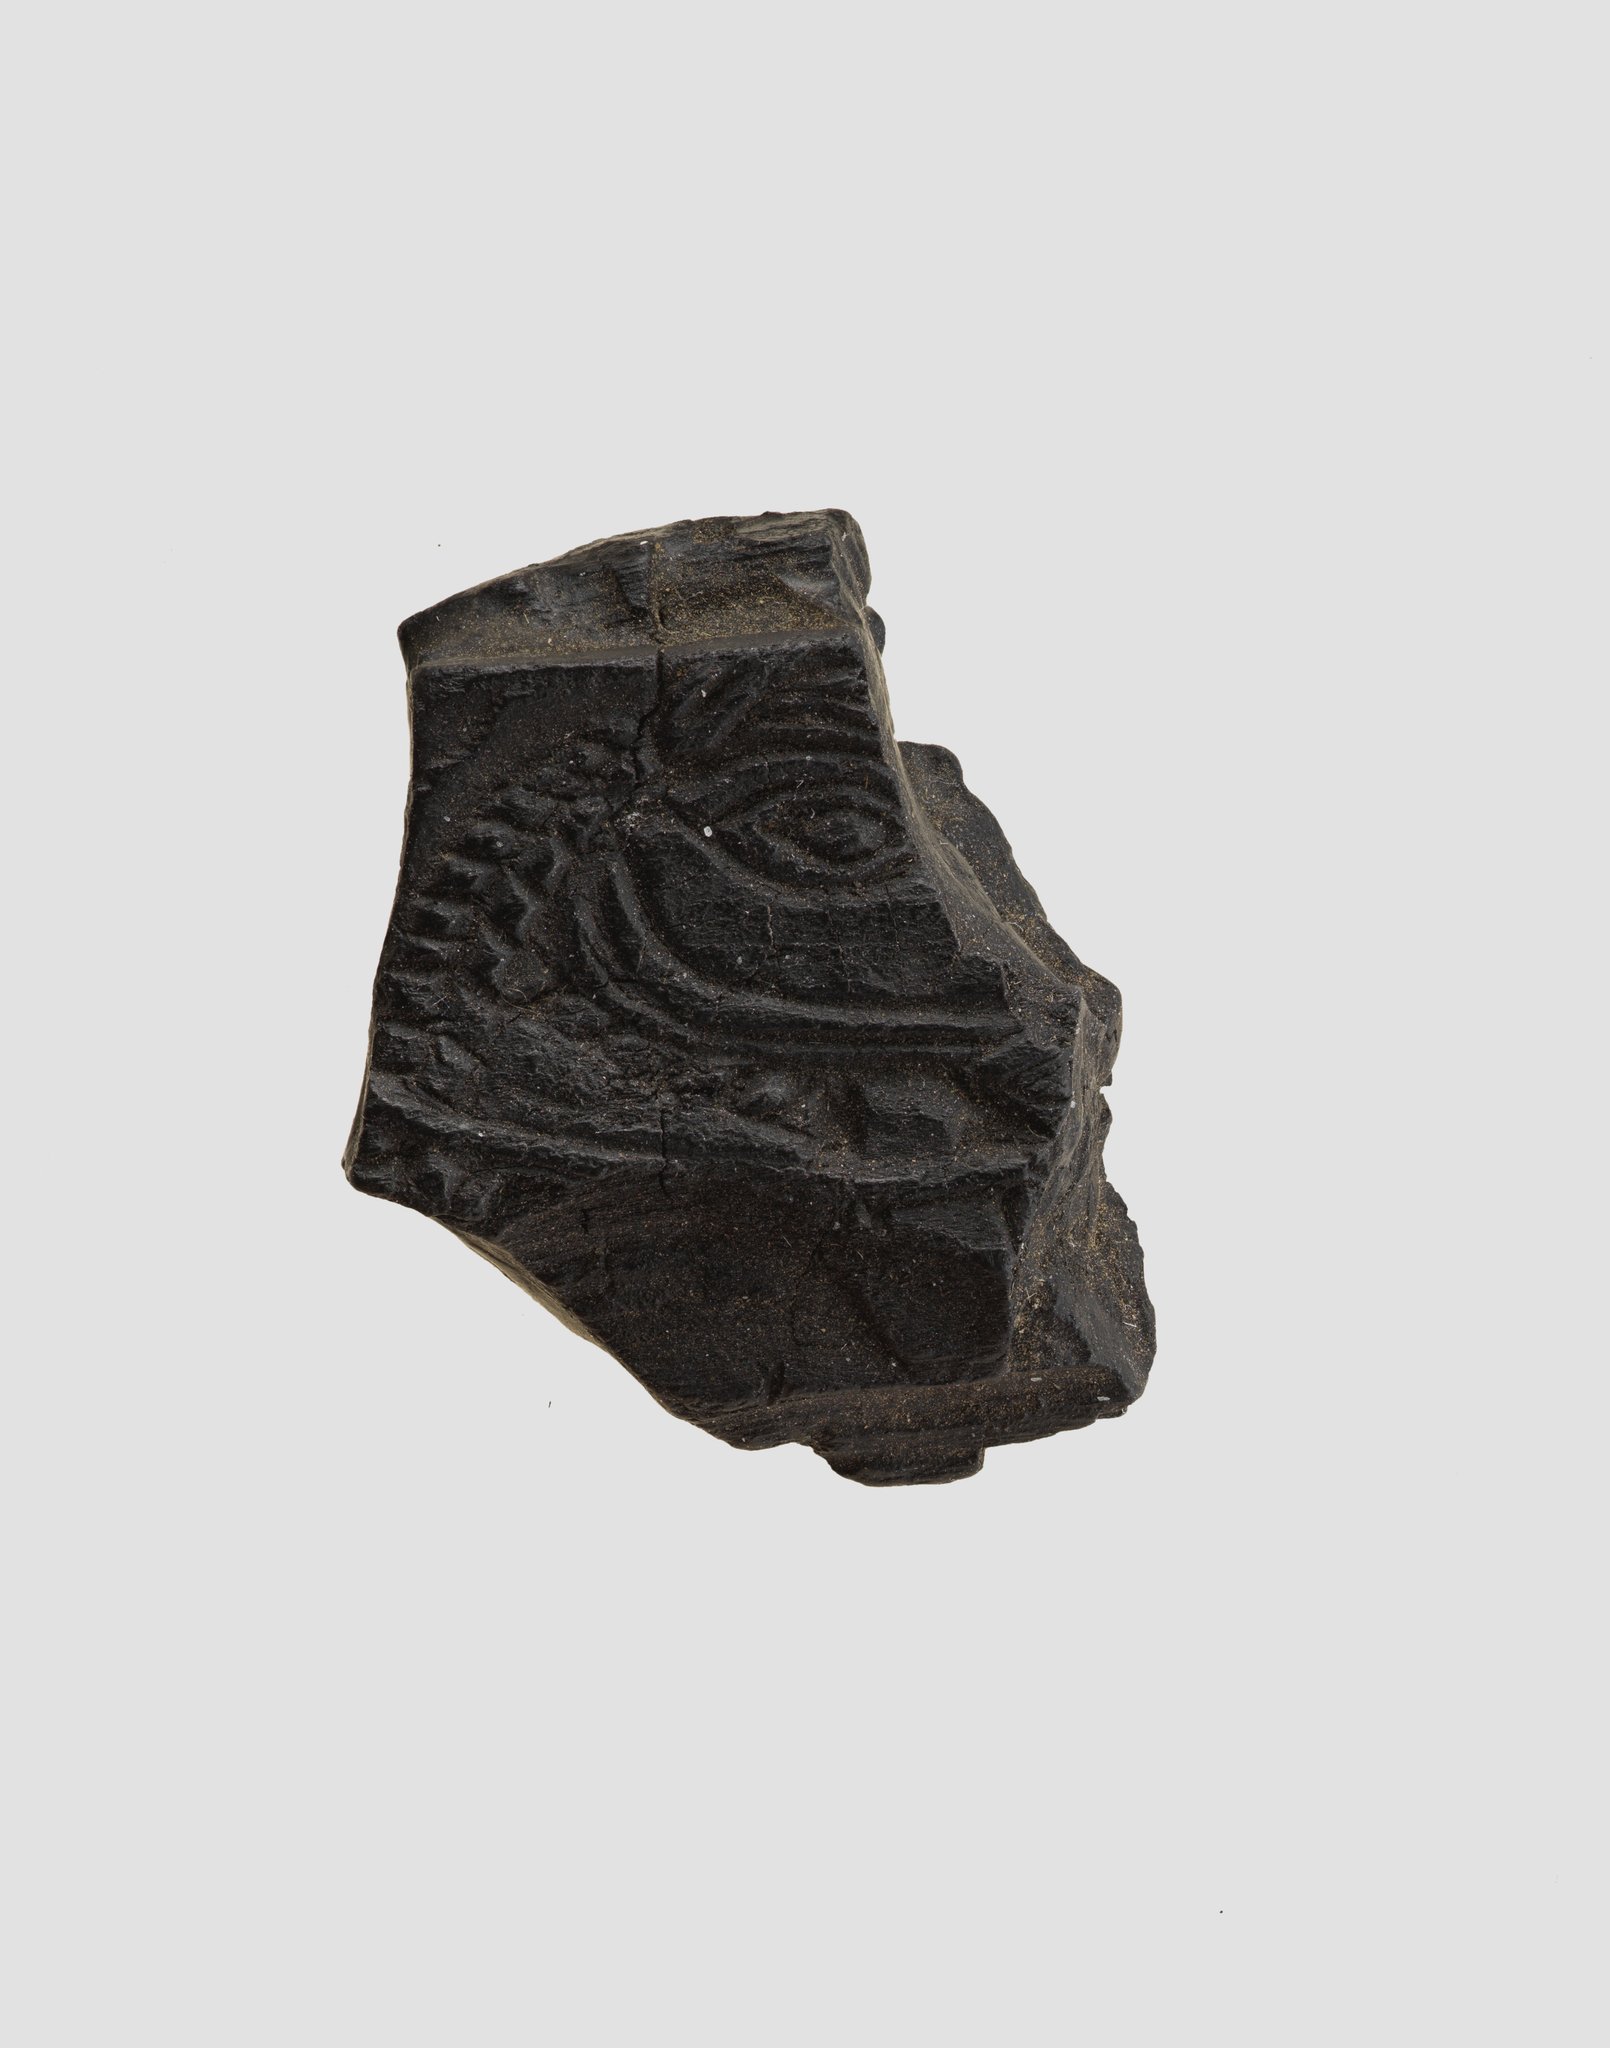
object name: relief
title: Relief fragment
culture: iranian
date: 900-801 BCE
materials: wood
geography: iran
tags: horses